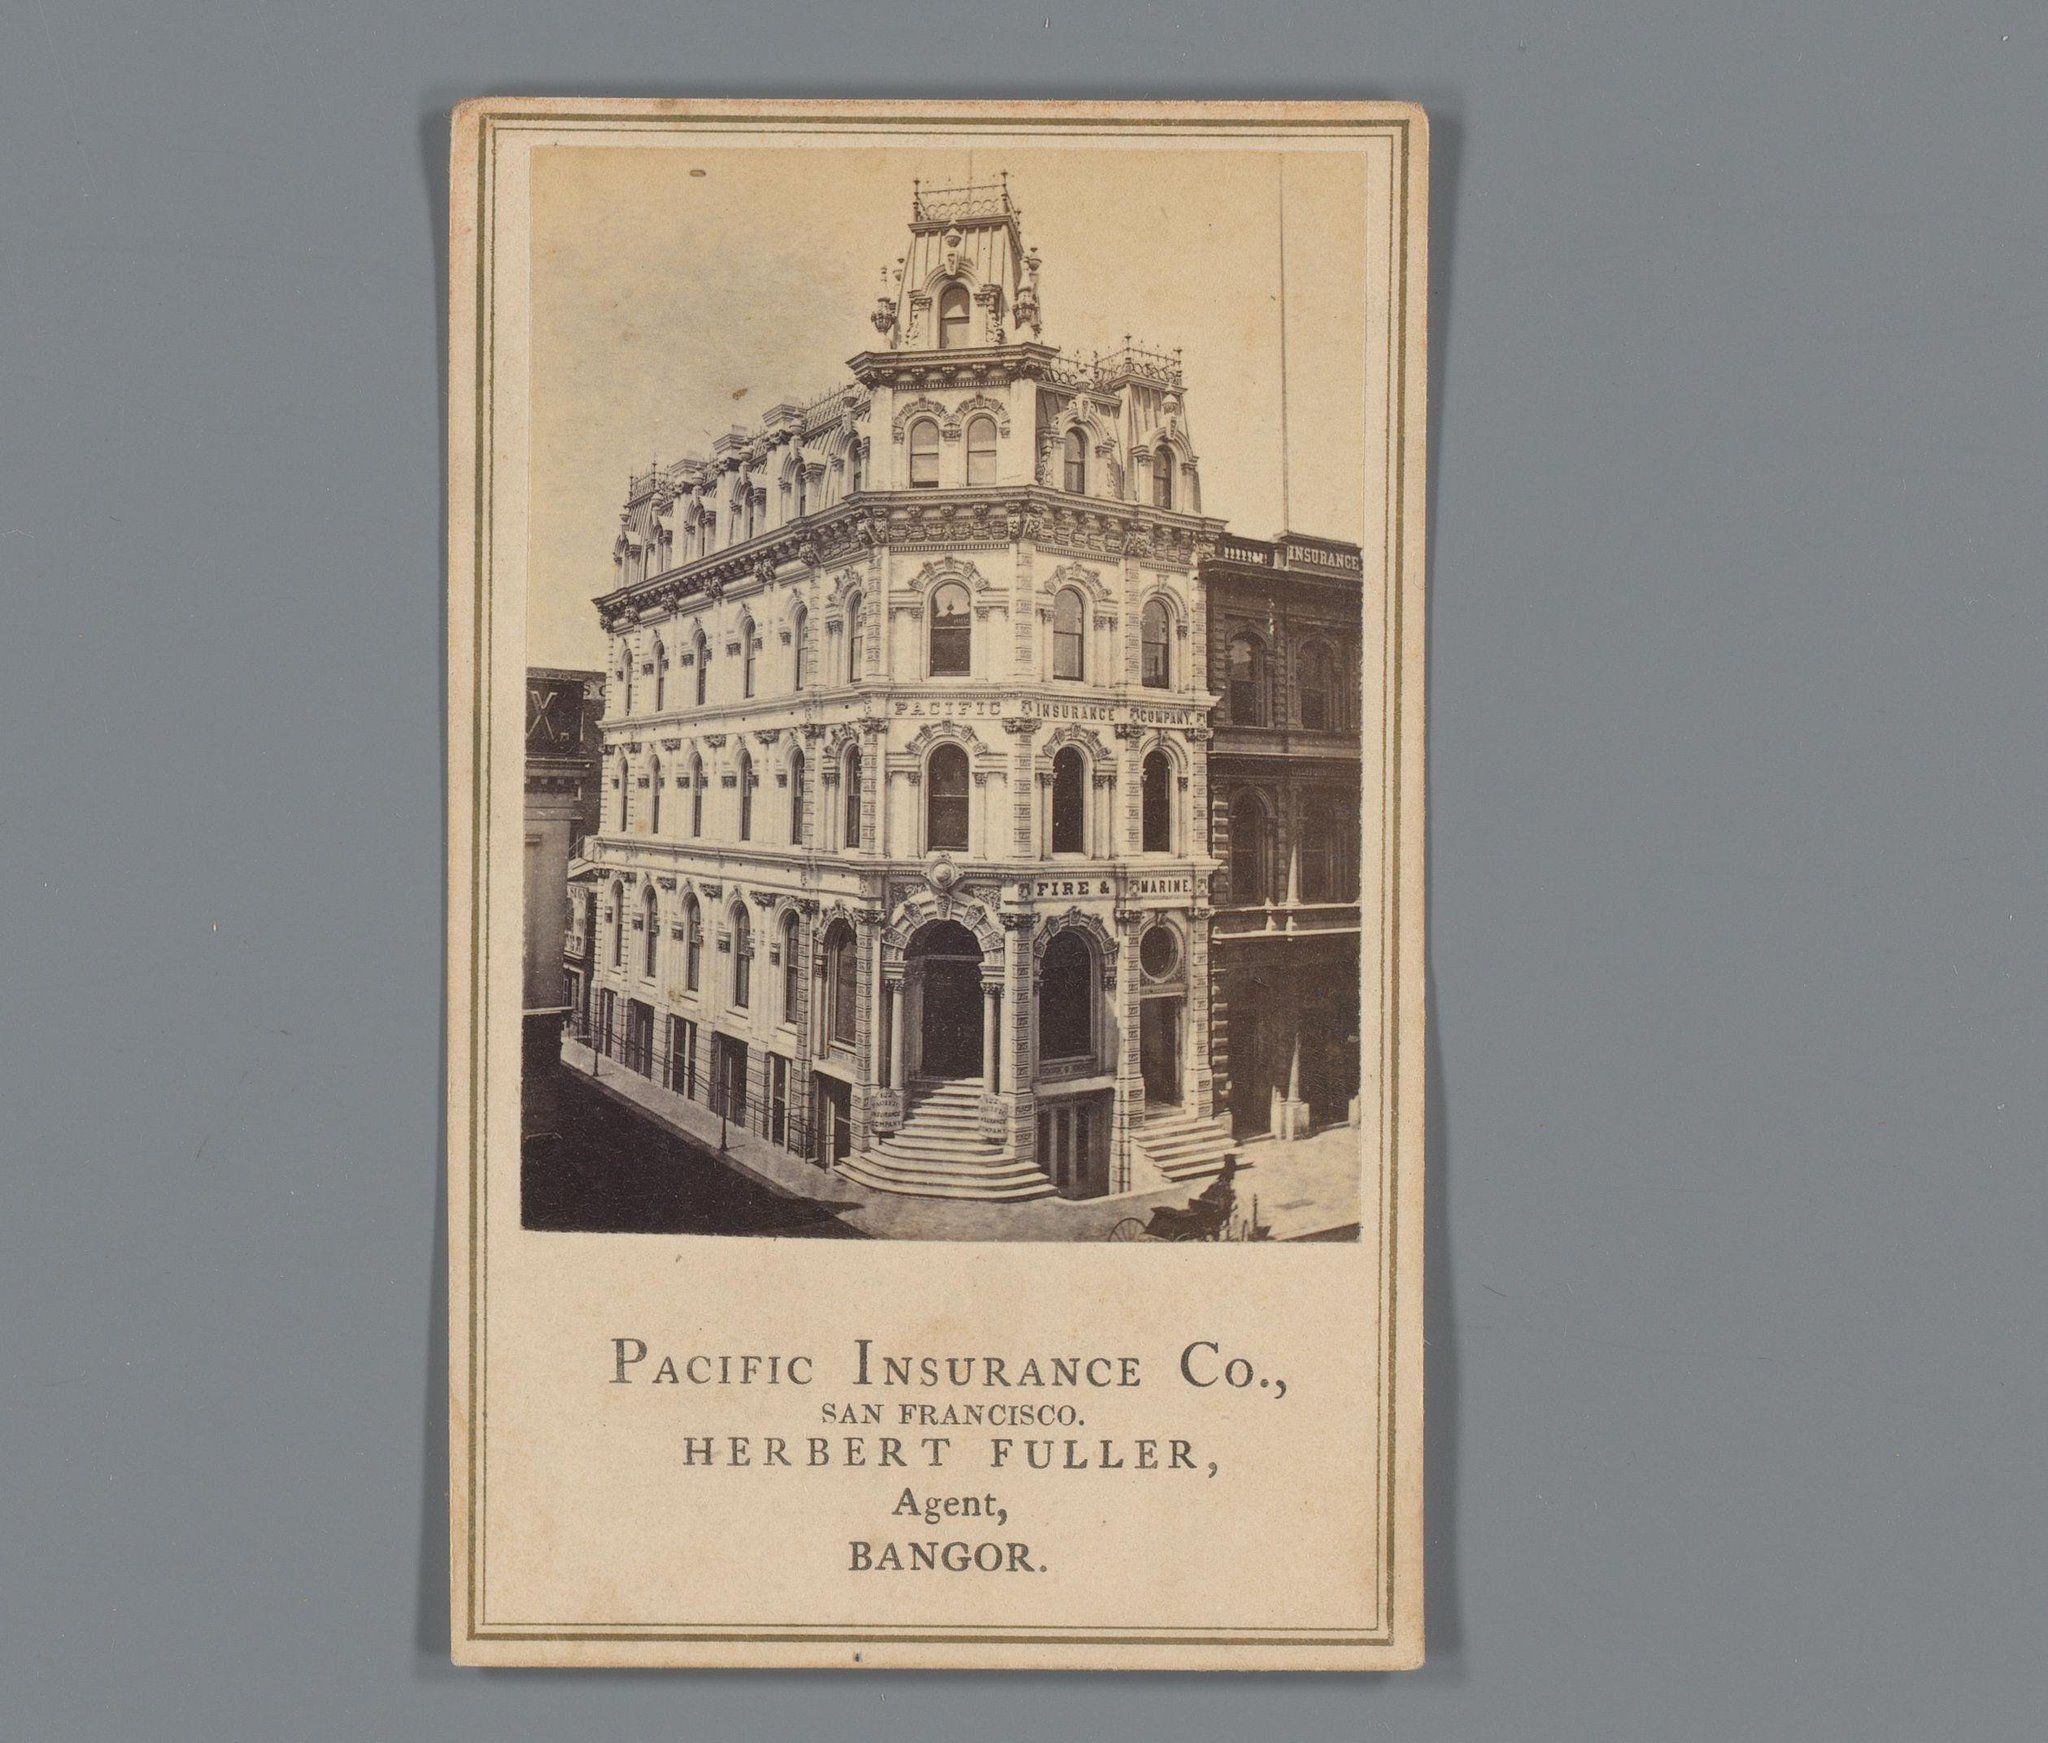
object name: photograph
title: Reclame voor de Pacific Insurance Company met gezicht op het kantoorpand in San Francisco, Californië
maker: Anonymous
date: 1850-1915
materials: cardboard, photographic support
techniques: albumen print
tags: advertising, organization of trade and finance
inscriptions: inscription: ‘(...)’